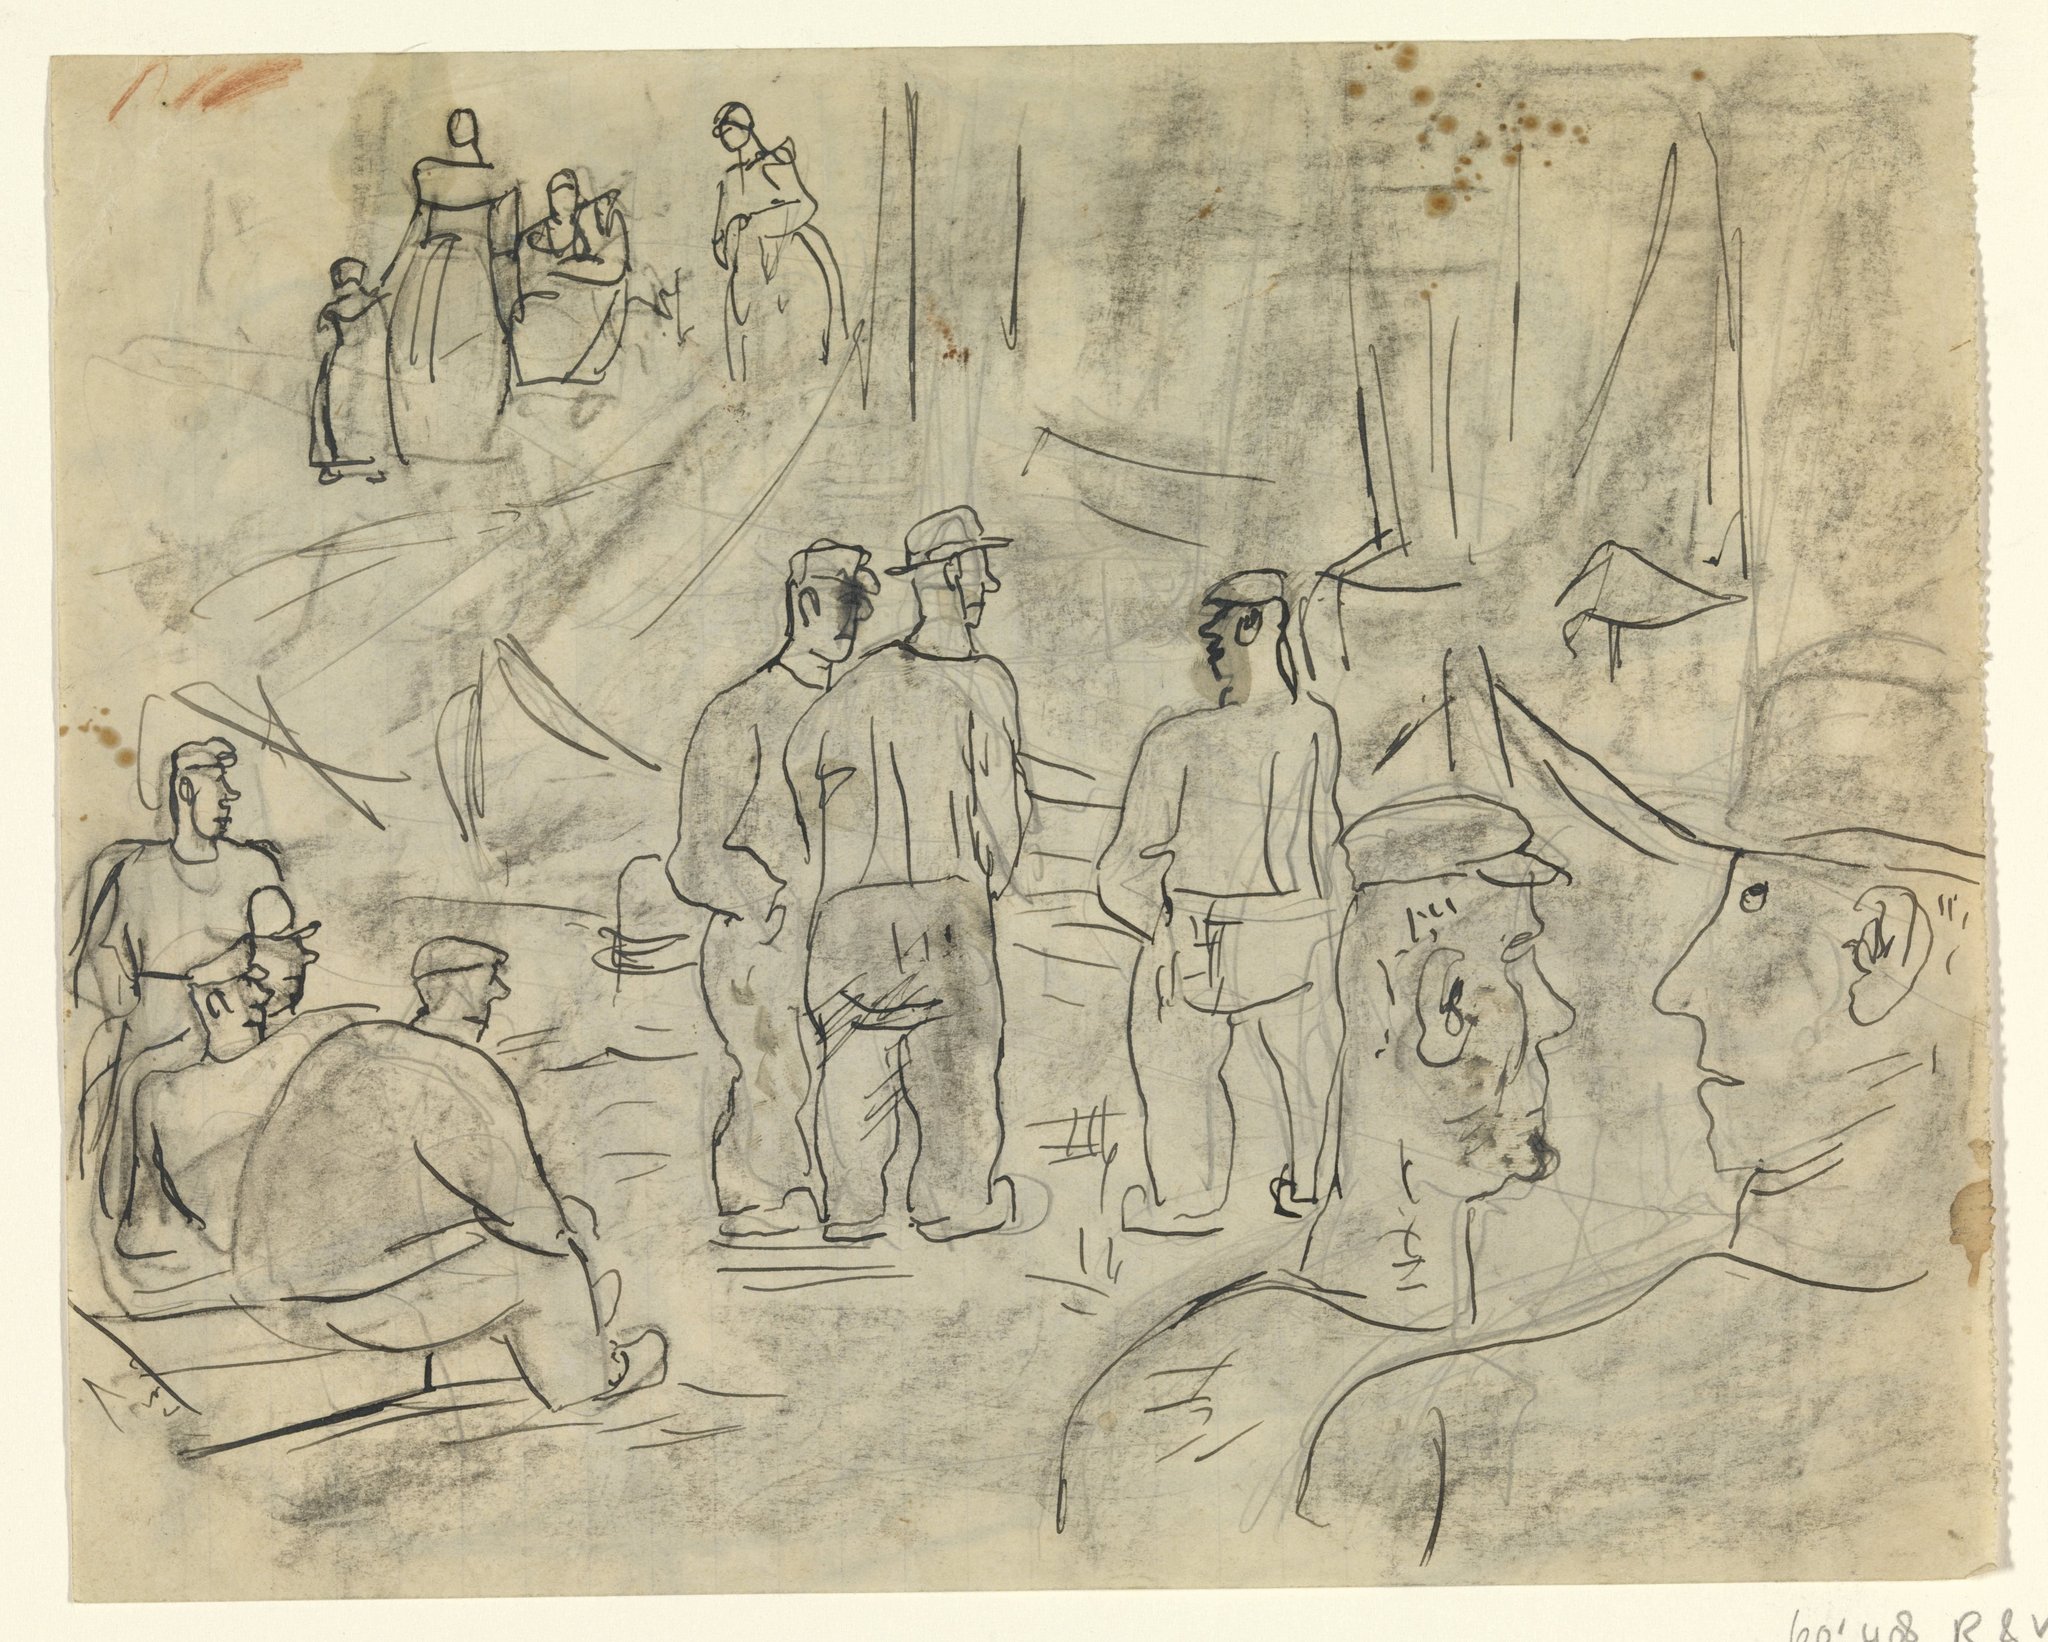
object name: drawing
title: Vissers in een haven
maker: leo gestel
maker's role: draughtsman, print maker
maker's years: 1881-1941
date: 1891-1941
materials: charcoal, ink, paper, pencil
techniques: pen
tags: harbour, commercial fishery, ships (in general), fisherman